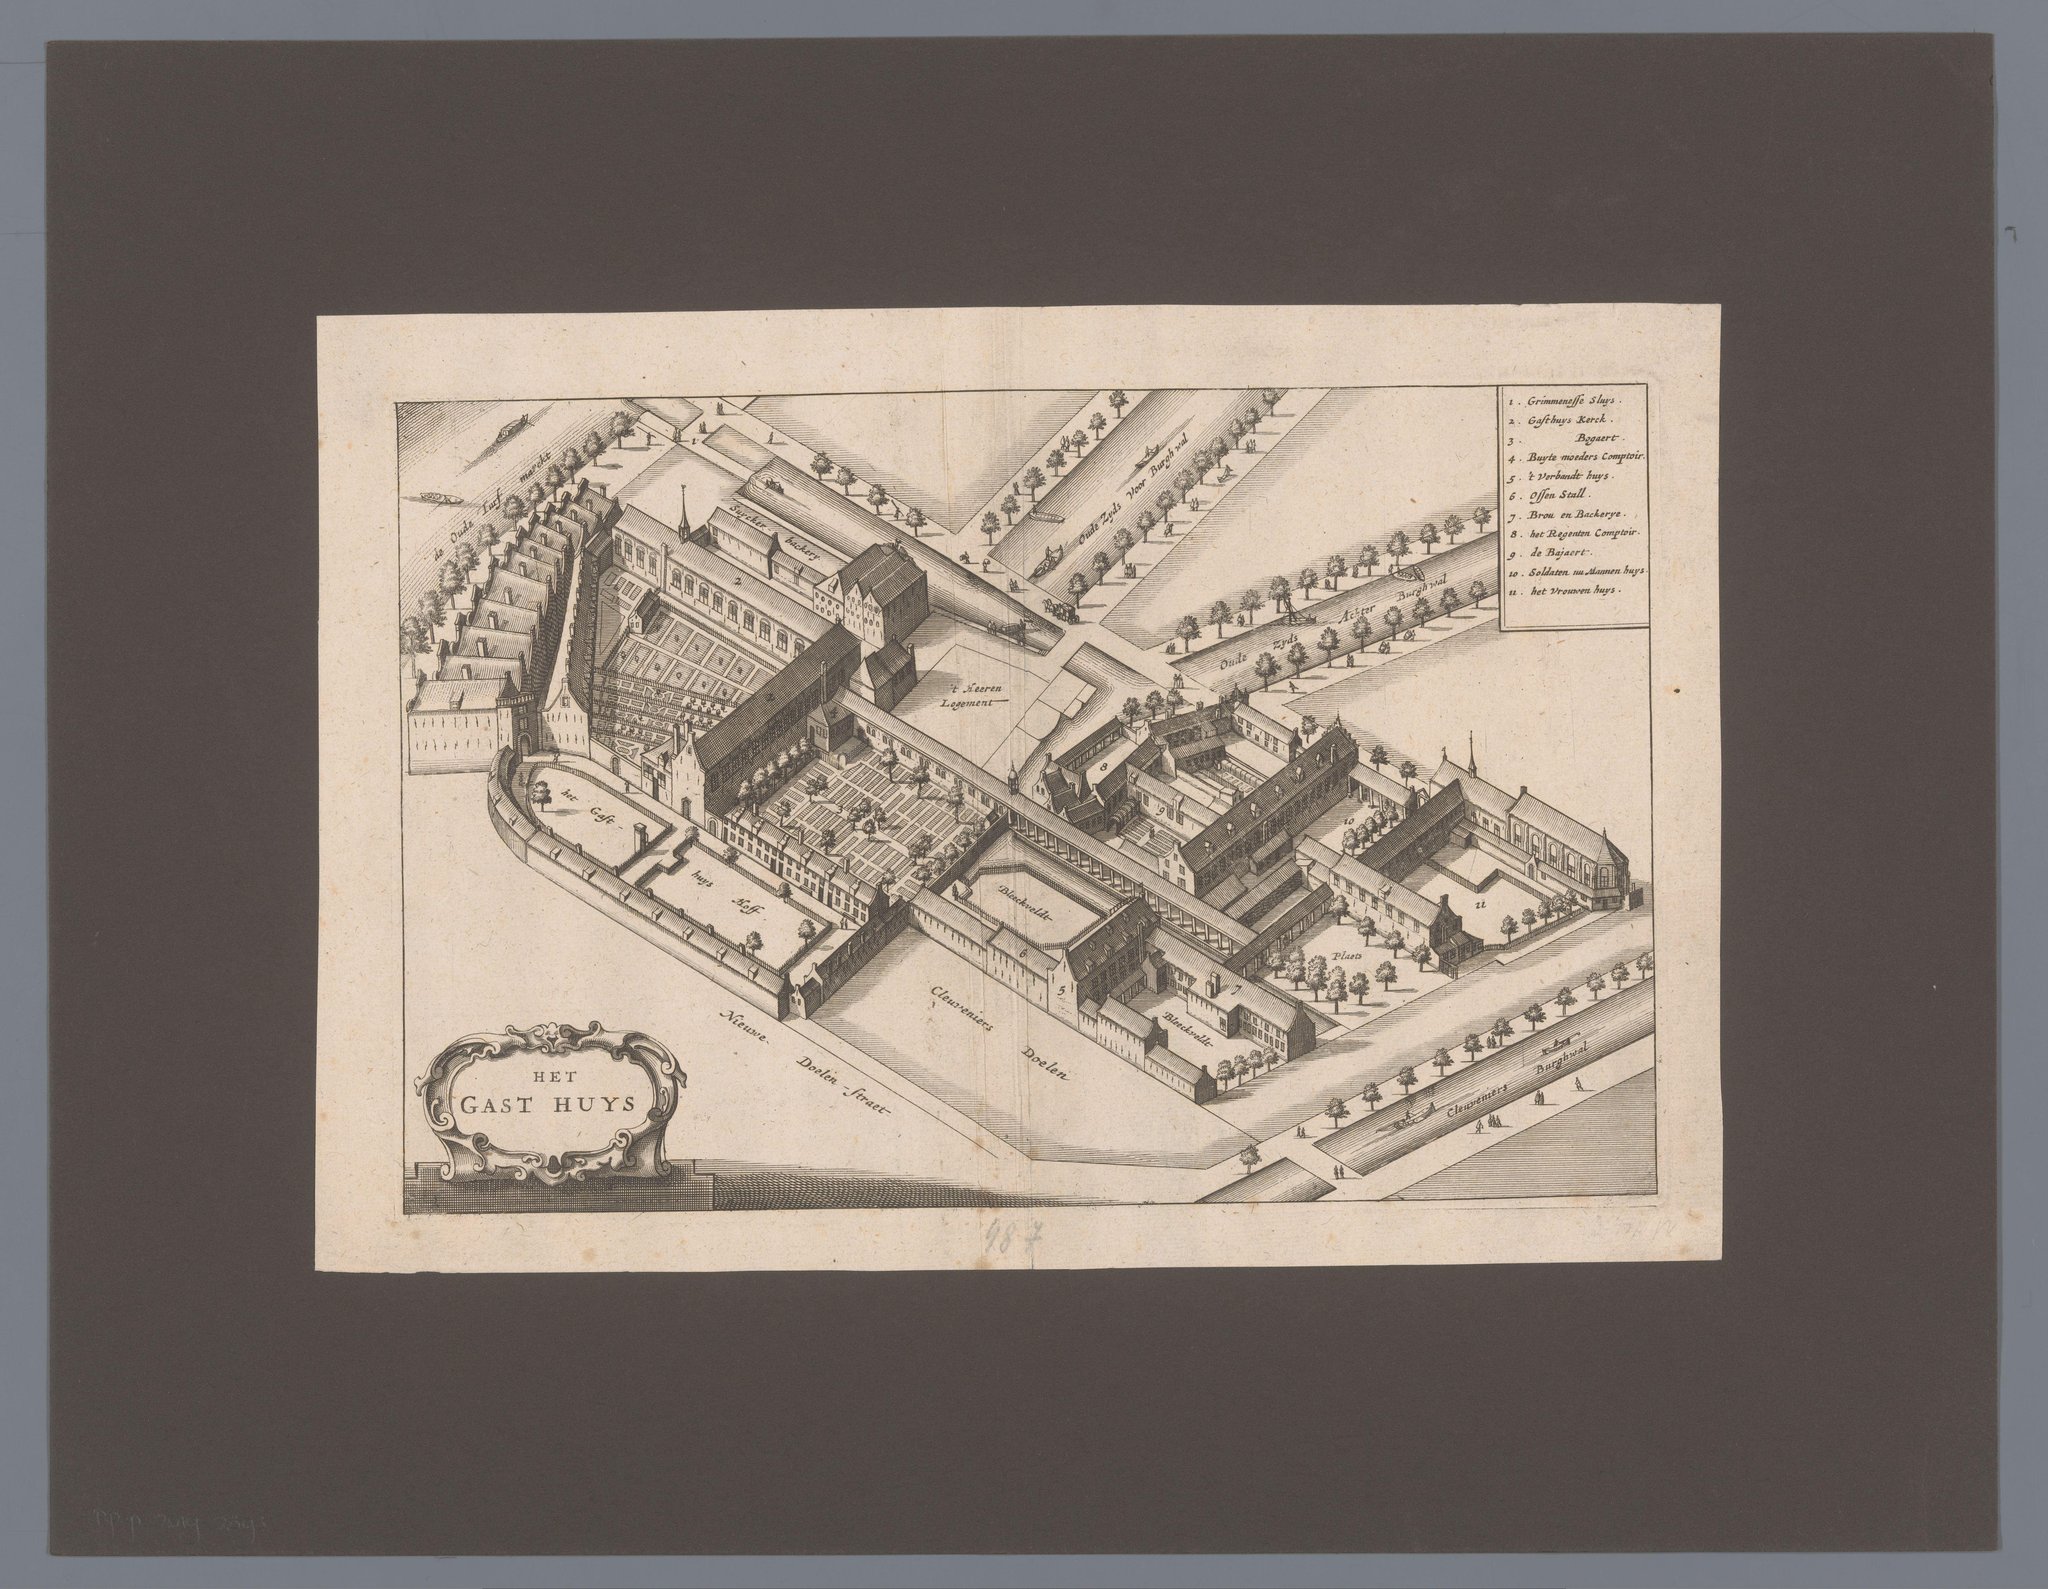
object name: print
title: Het Gast huys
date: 1663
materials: paper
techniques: engraving, etching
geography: amsterdam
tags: hospital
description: Prent uit: Dapper, Olfert. Historische beschryving der stadt Amsterdam (...). 2 dln. Amsterdam: Jacob van Meurs, 1663, dl. 1, p. 404. Later ook uitgegeven in: Zesen, Philip von. Beschreibung der stadt Amsterdam (...). Amsterdam: Joachim Noschen, 1664, p. 88.